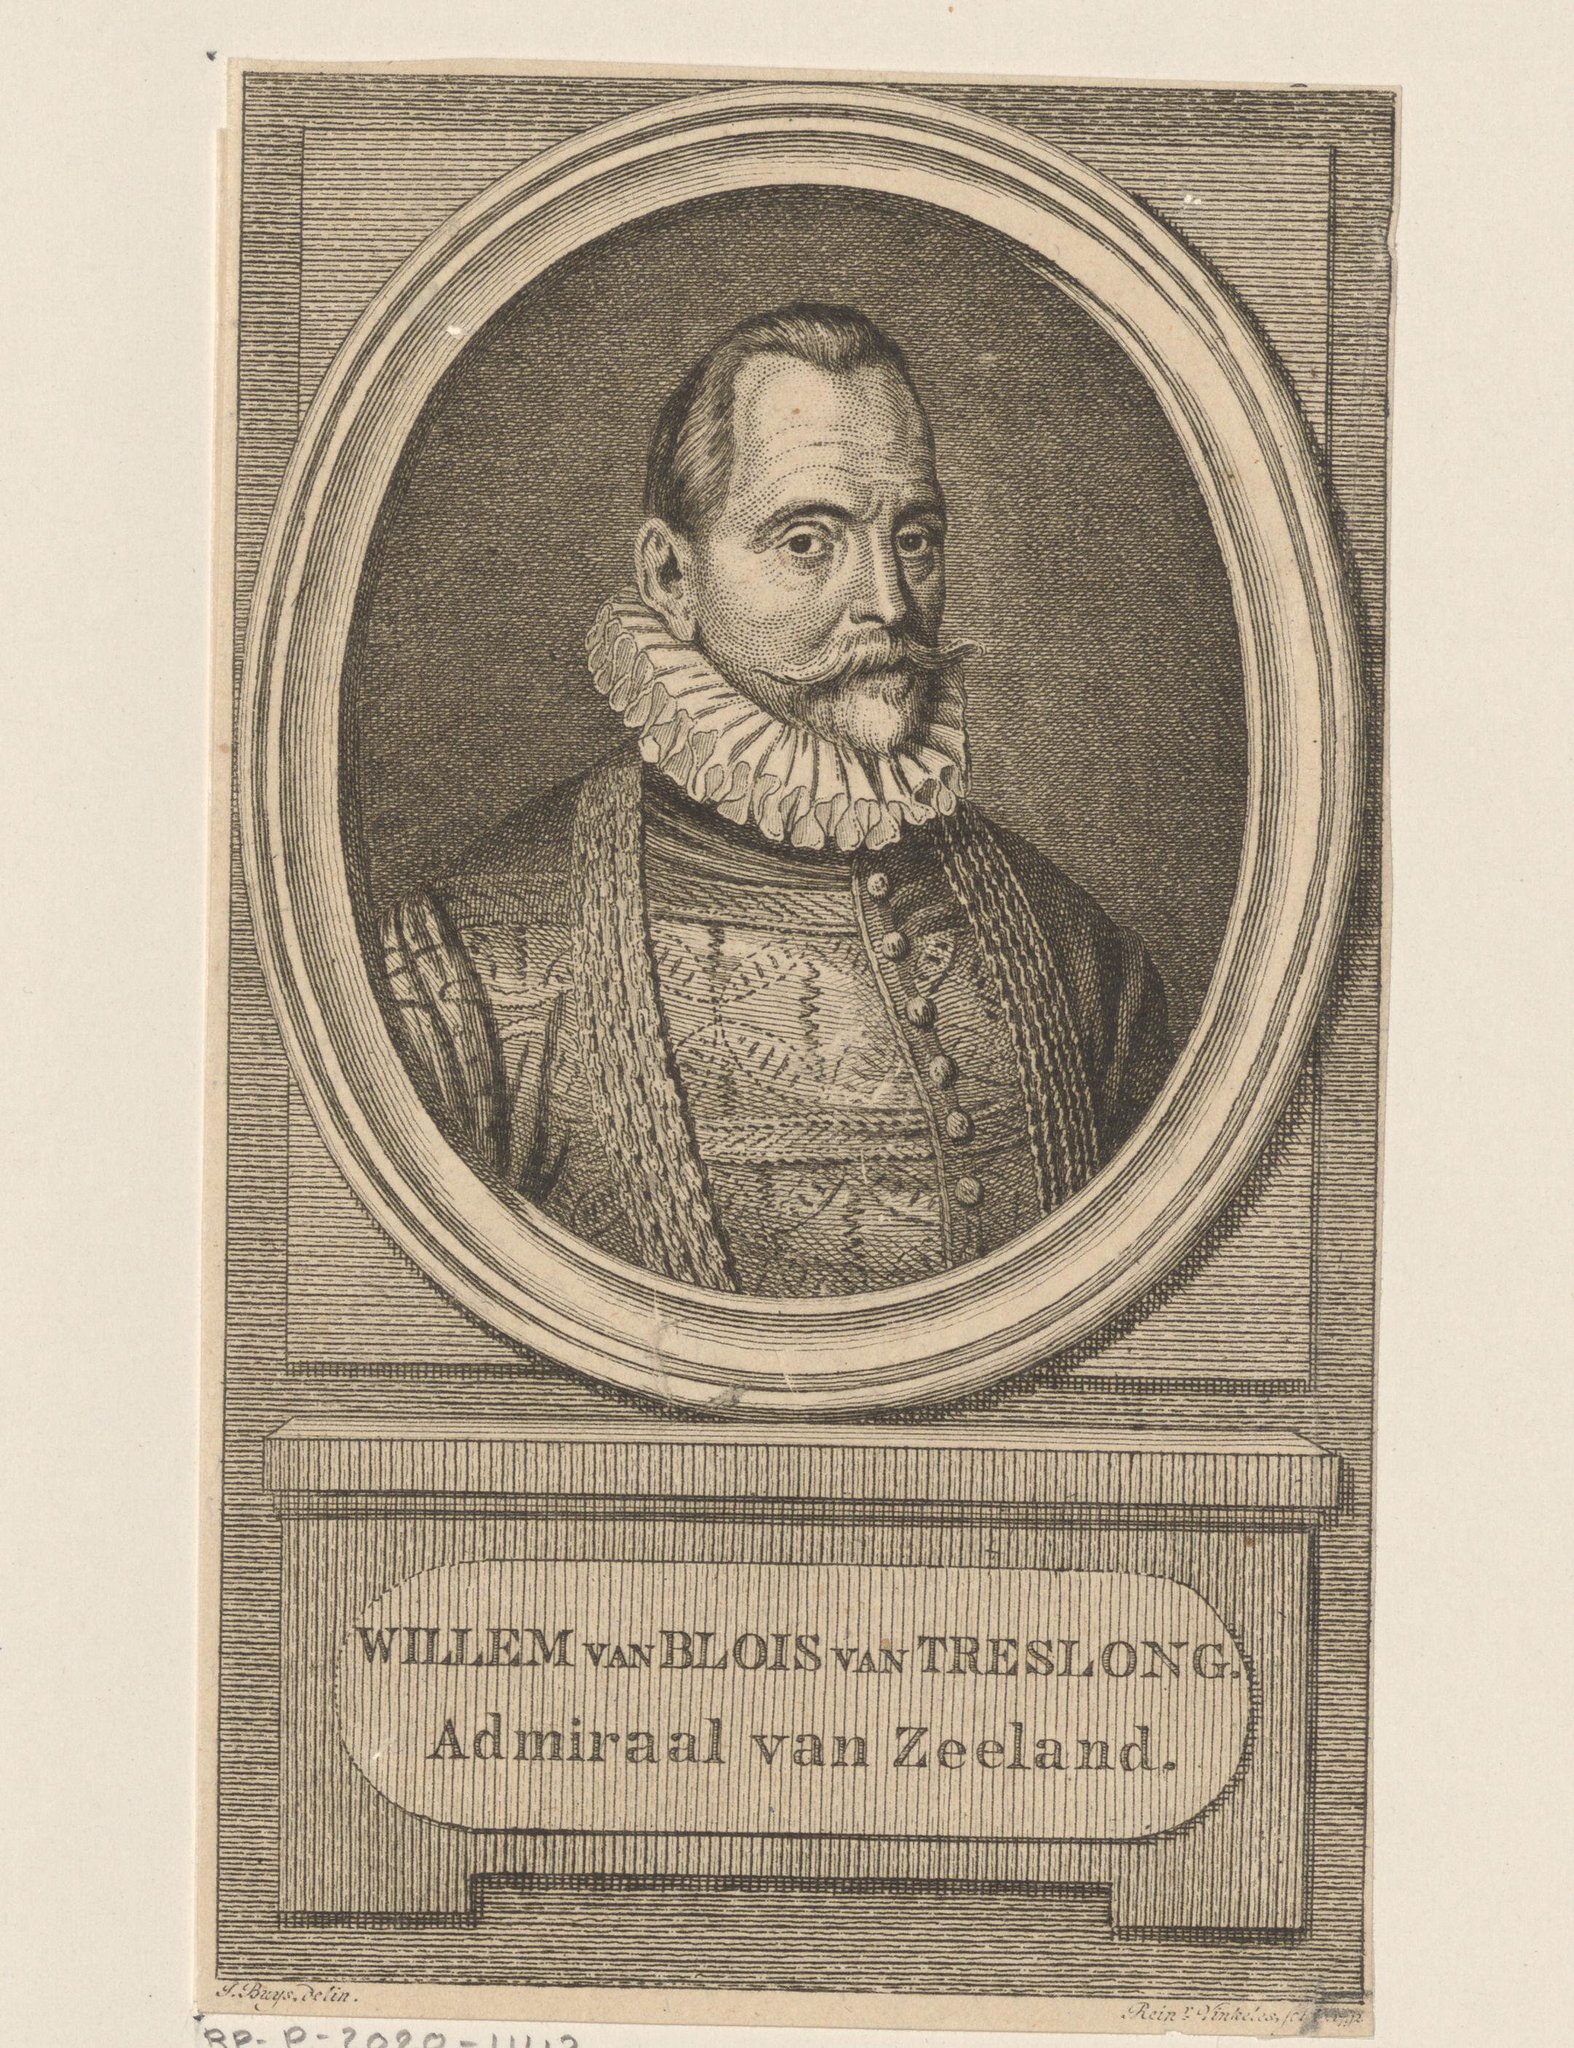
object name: book illustration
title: Portret van Willem van Bloys van Treslong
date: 1792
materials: paper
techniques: engraving, etching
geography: amsterdam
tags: brielle, historical persons, commander-in-chief, admiral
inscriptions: date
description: Prent uit: Kok, Jacobus. Vaderlandsch woordenboek : met kaarten, plaaten en pourtraitten. Amsterdam: Johannes Allart, 1785-1796, dl. 28.